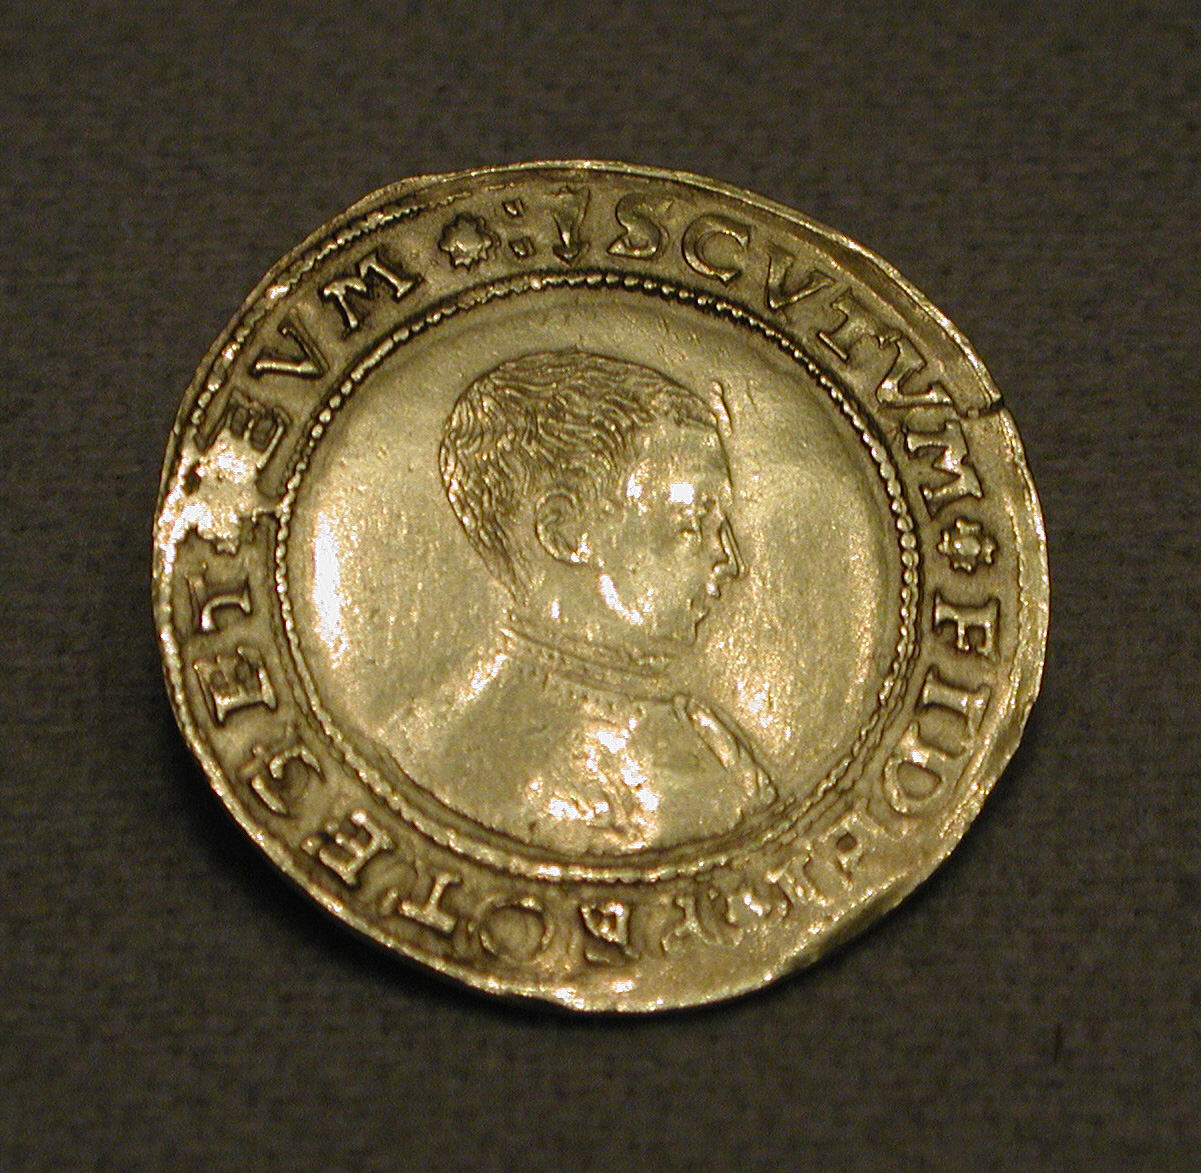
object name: half sovereign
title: Half sovereign of Edward VI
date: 1549-1550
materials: gold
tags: kings,profiles